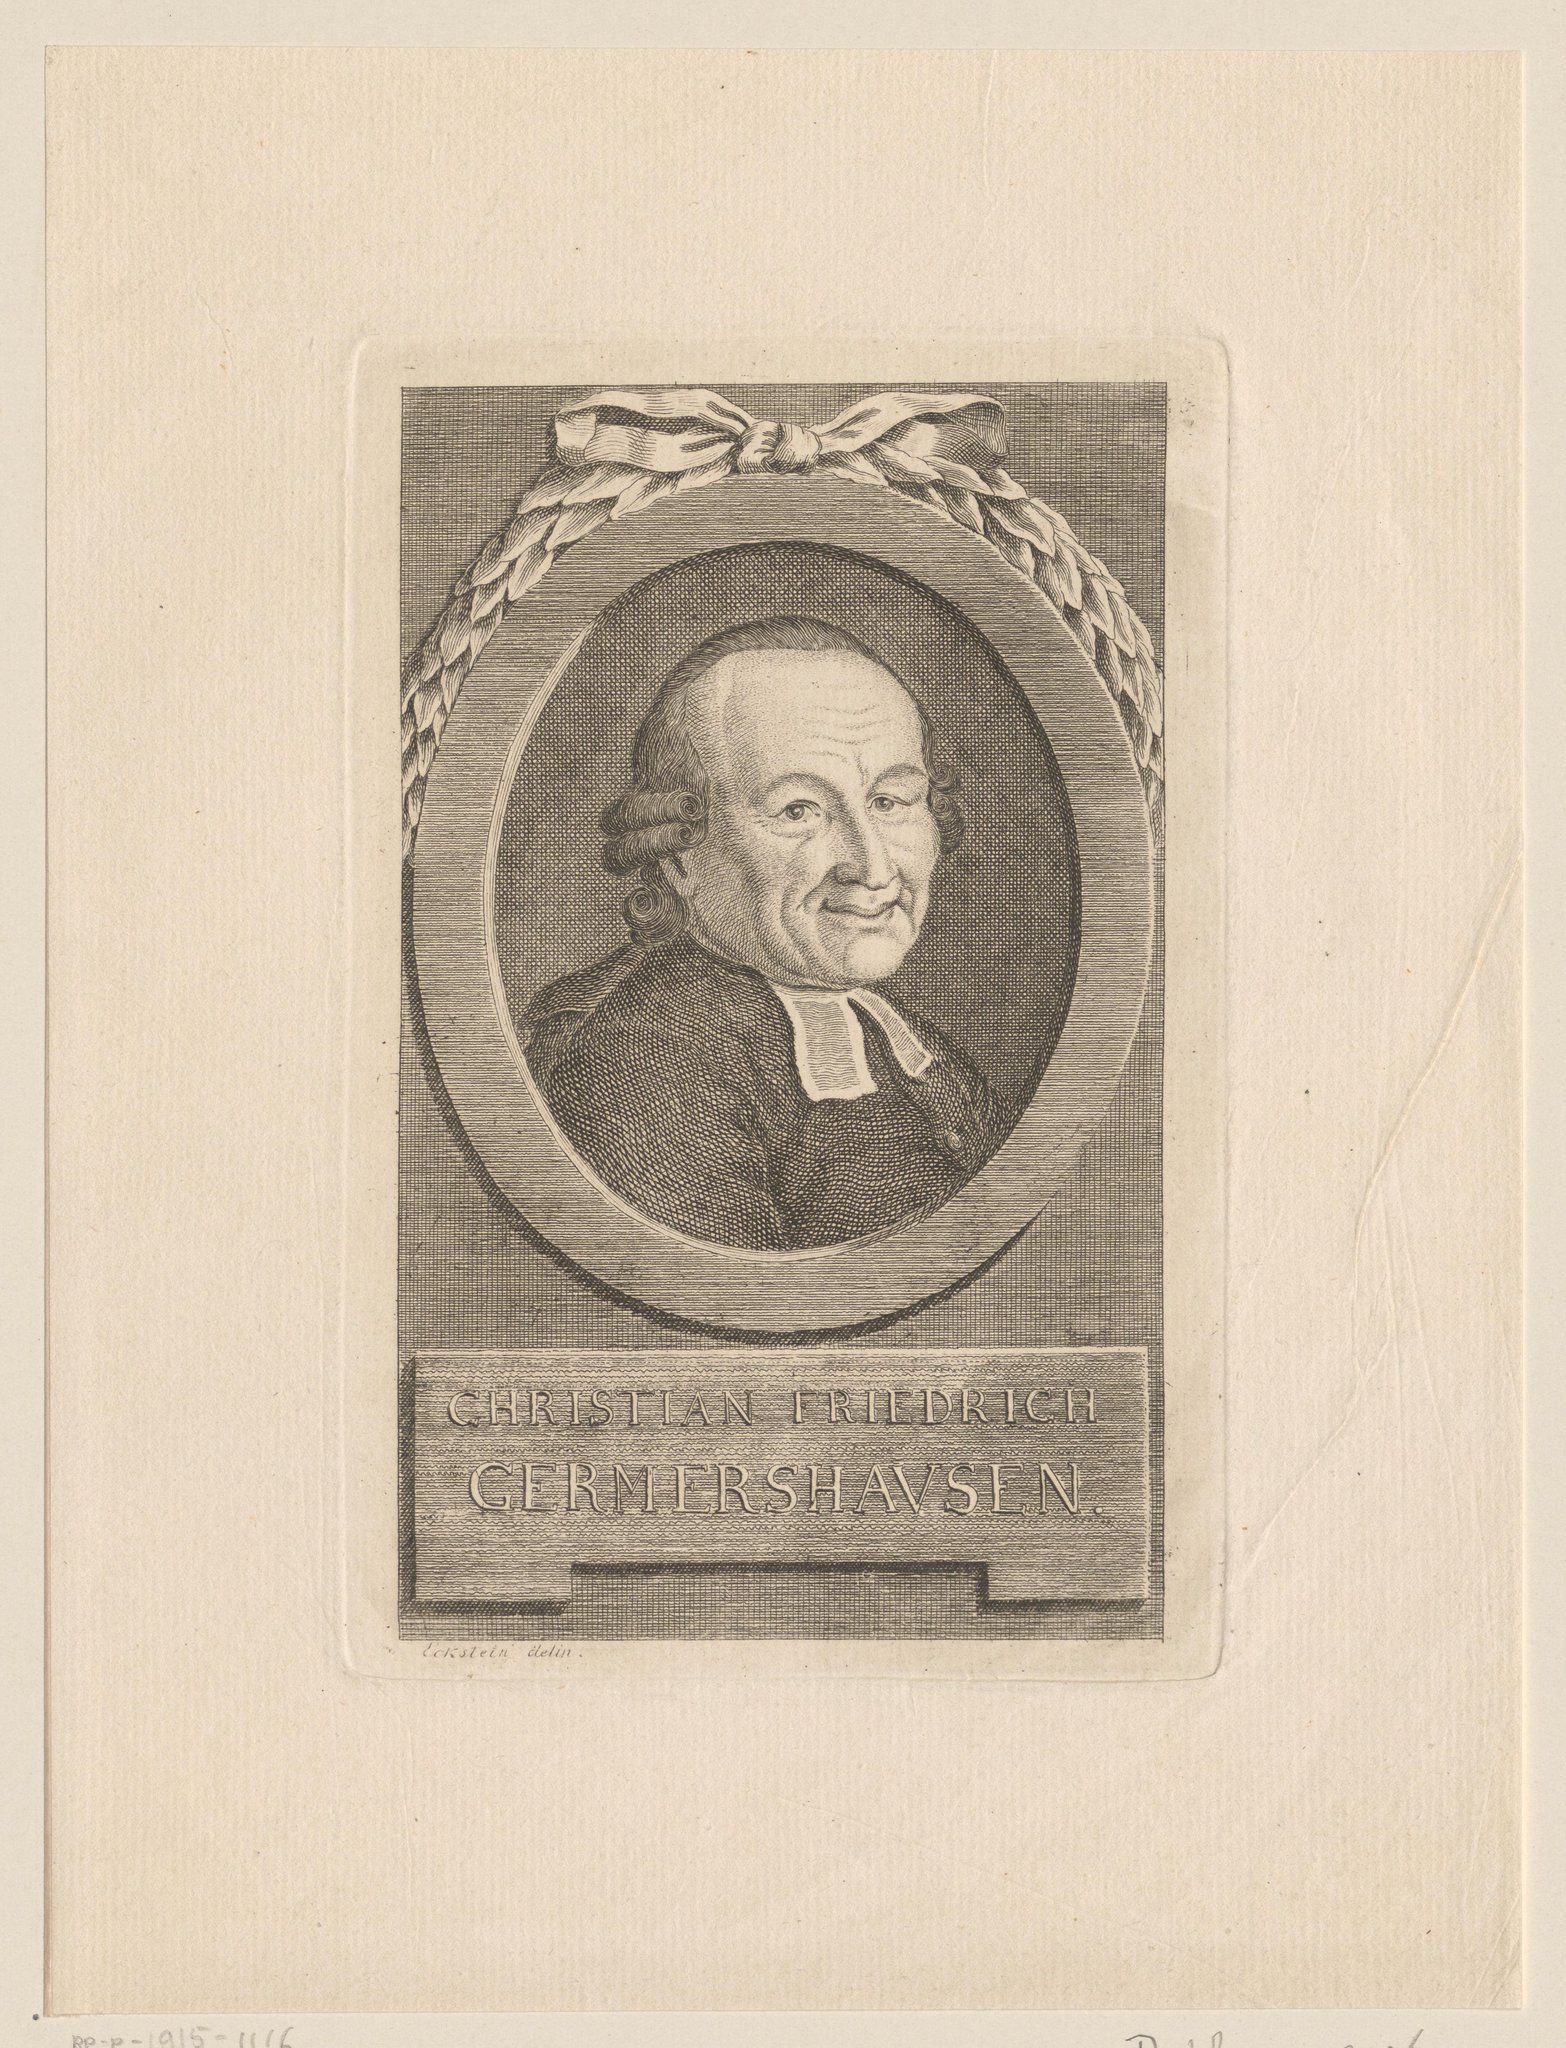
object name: print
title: Portret van Christian Friedrich Germeshaven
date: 1787-1838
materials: paper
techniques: engraving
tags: theologian, historical persons